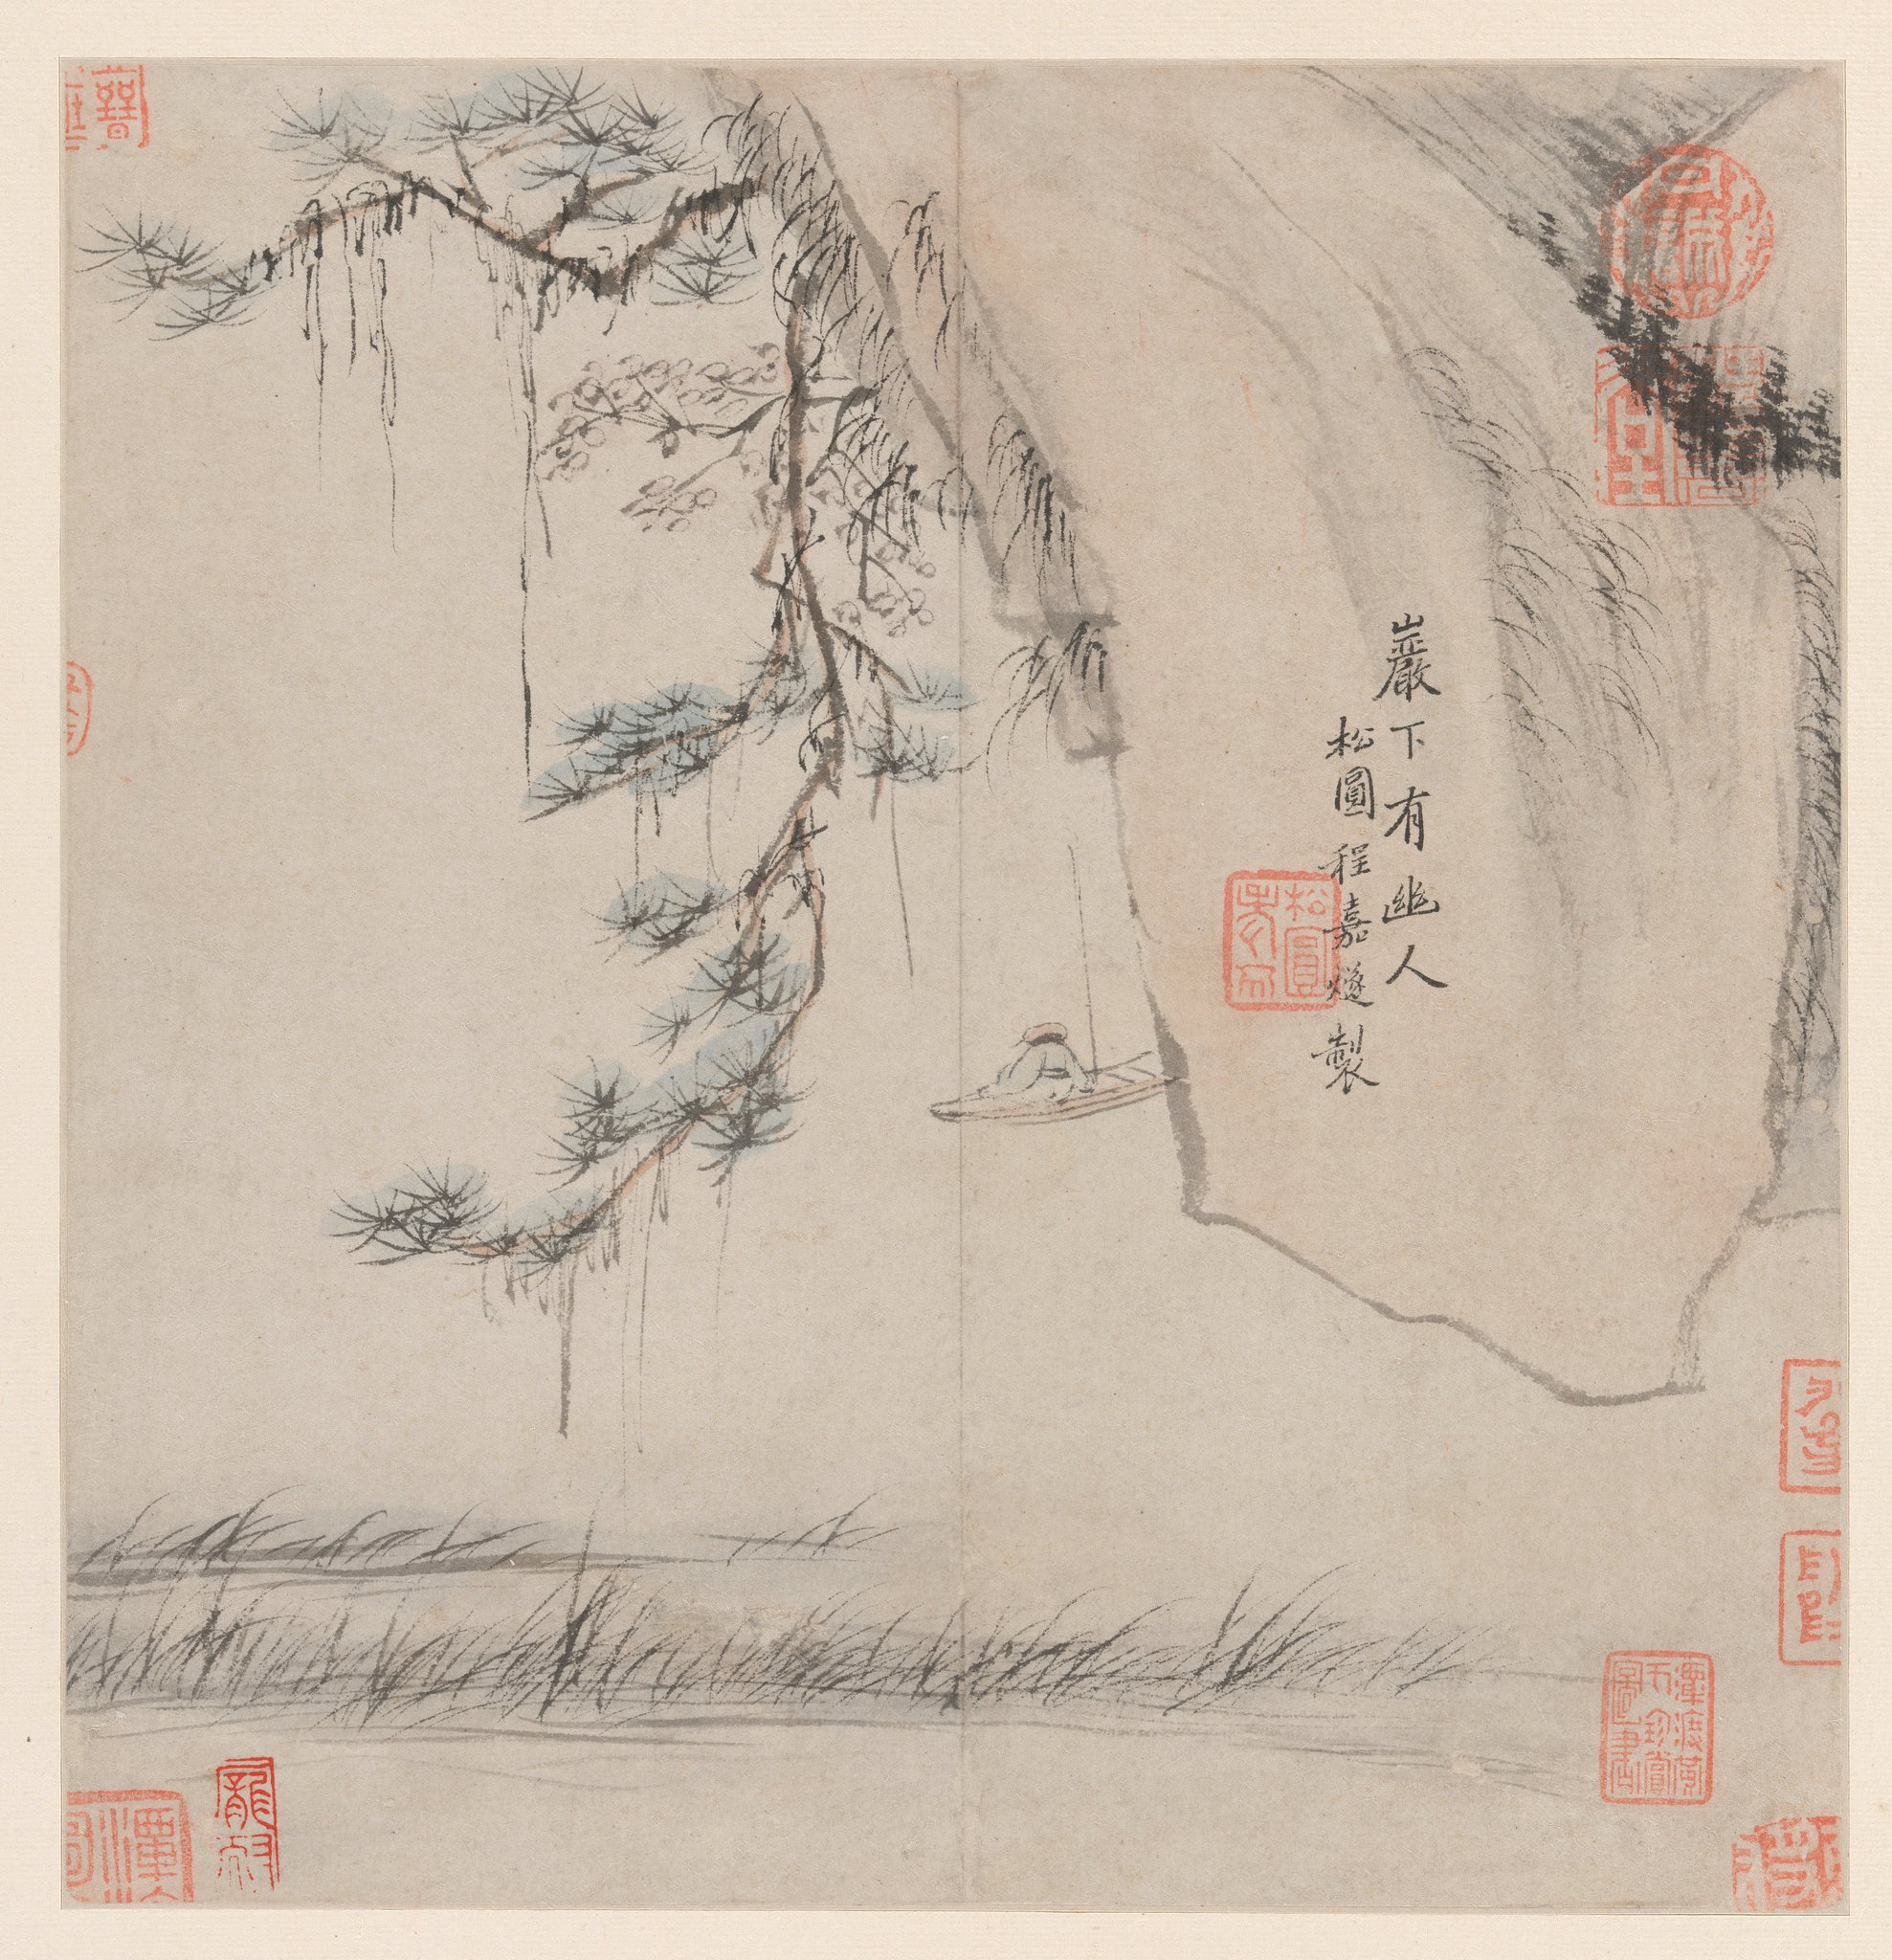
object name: two leaf from an album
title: Two Landscapes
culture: chinese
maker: cheng jiasui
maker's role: artist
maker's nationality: chinese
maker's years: 1565-1644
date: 1368-1644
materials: ink, paper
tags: landscapes